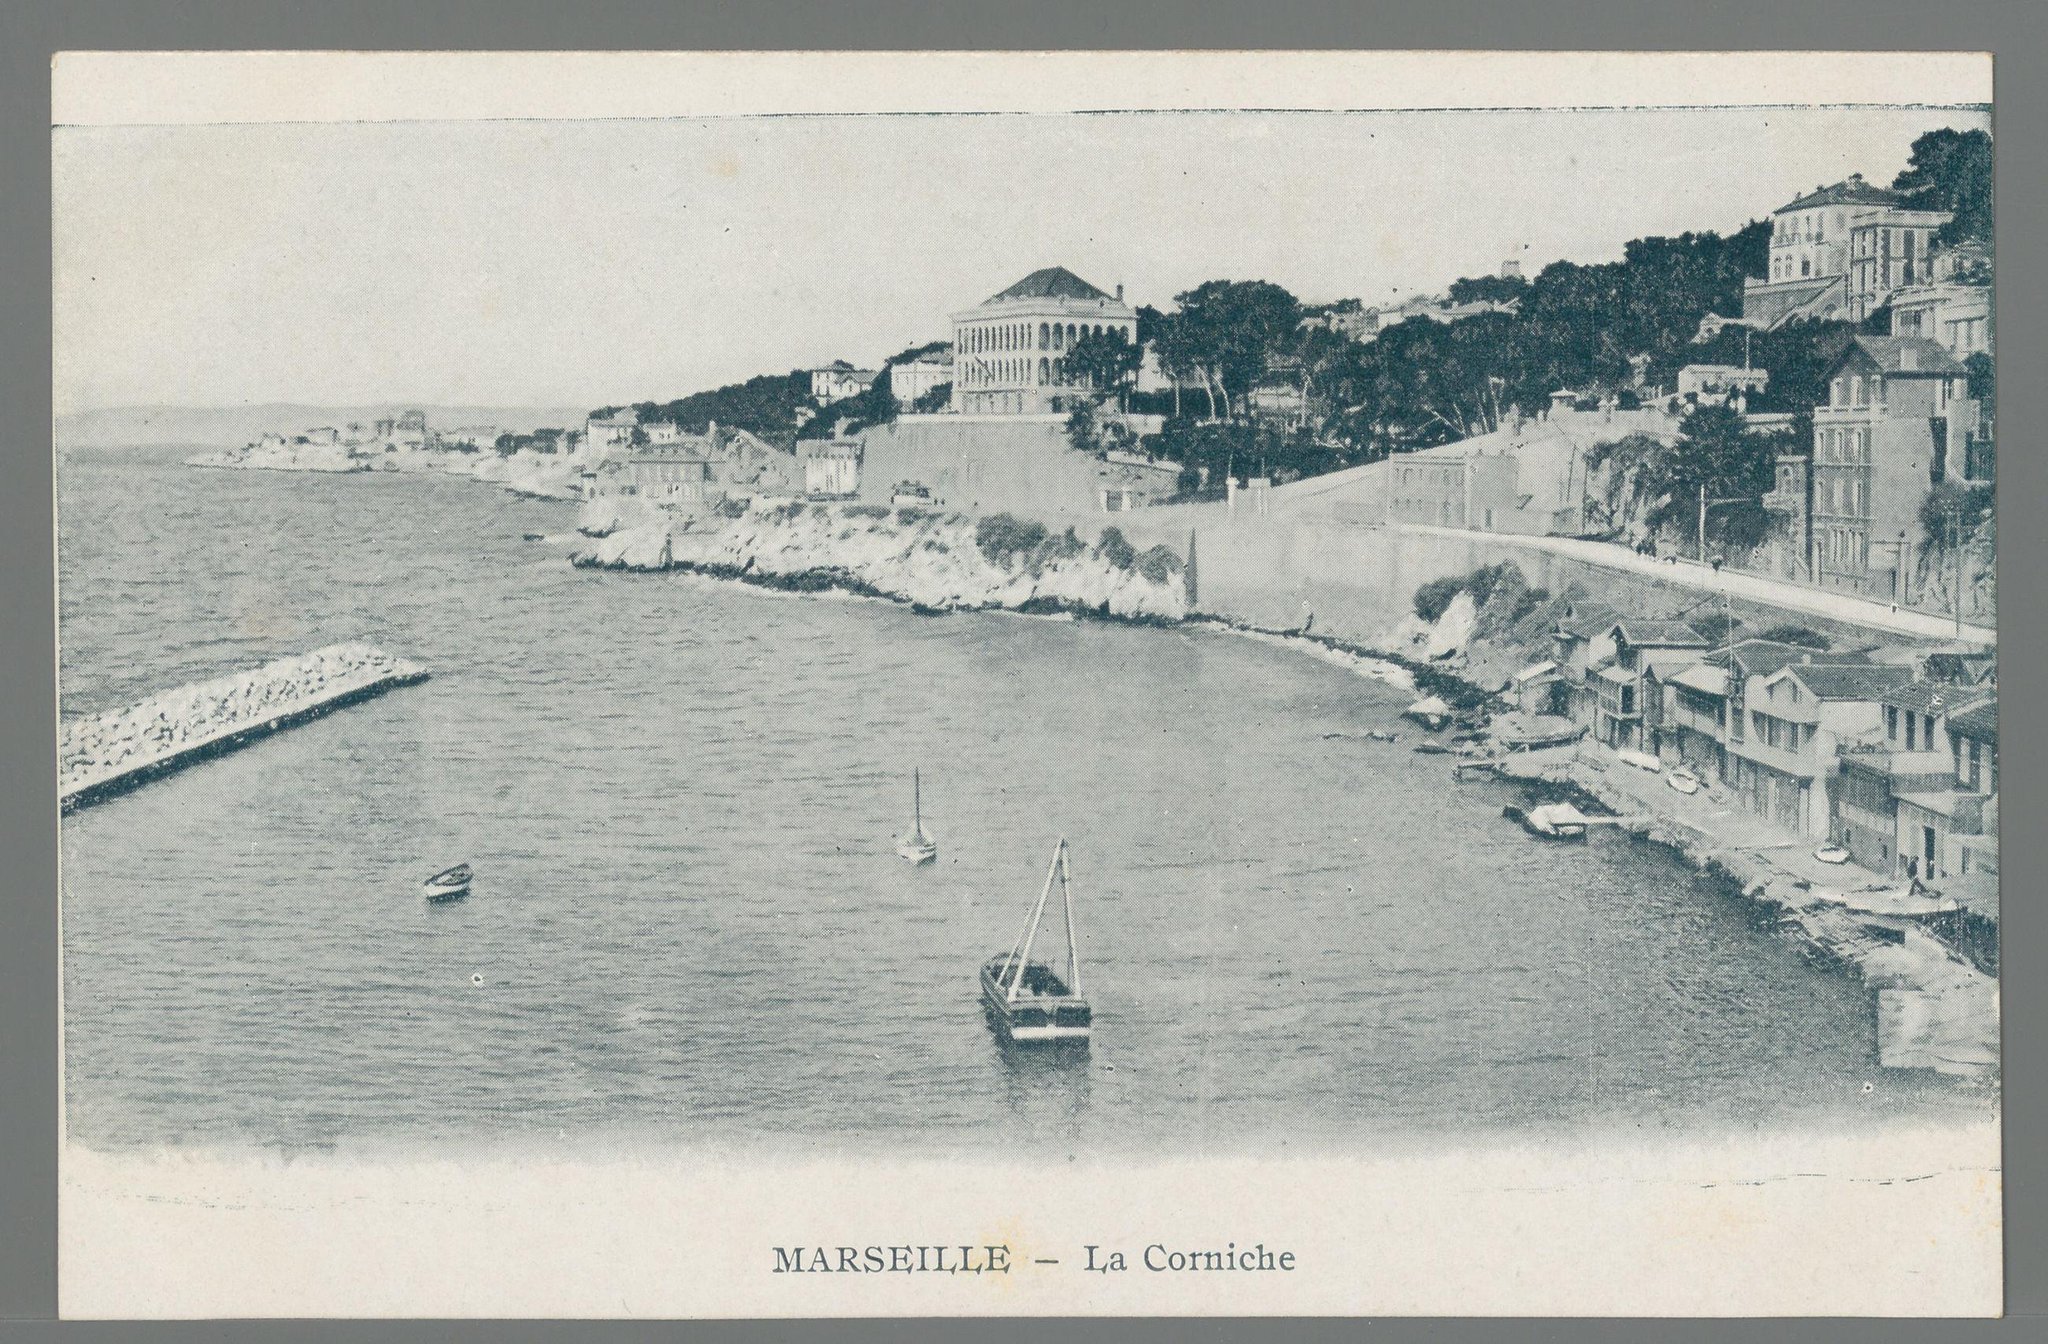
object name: photomechanical print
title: Marseille. La Corniche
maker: Anonymous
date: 1904-1906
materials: cardboard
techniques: autotype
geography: marseille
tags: rocky coast, ships (in general), sea (seascape), marseille